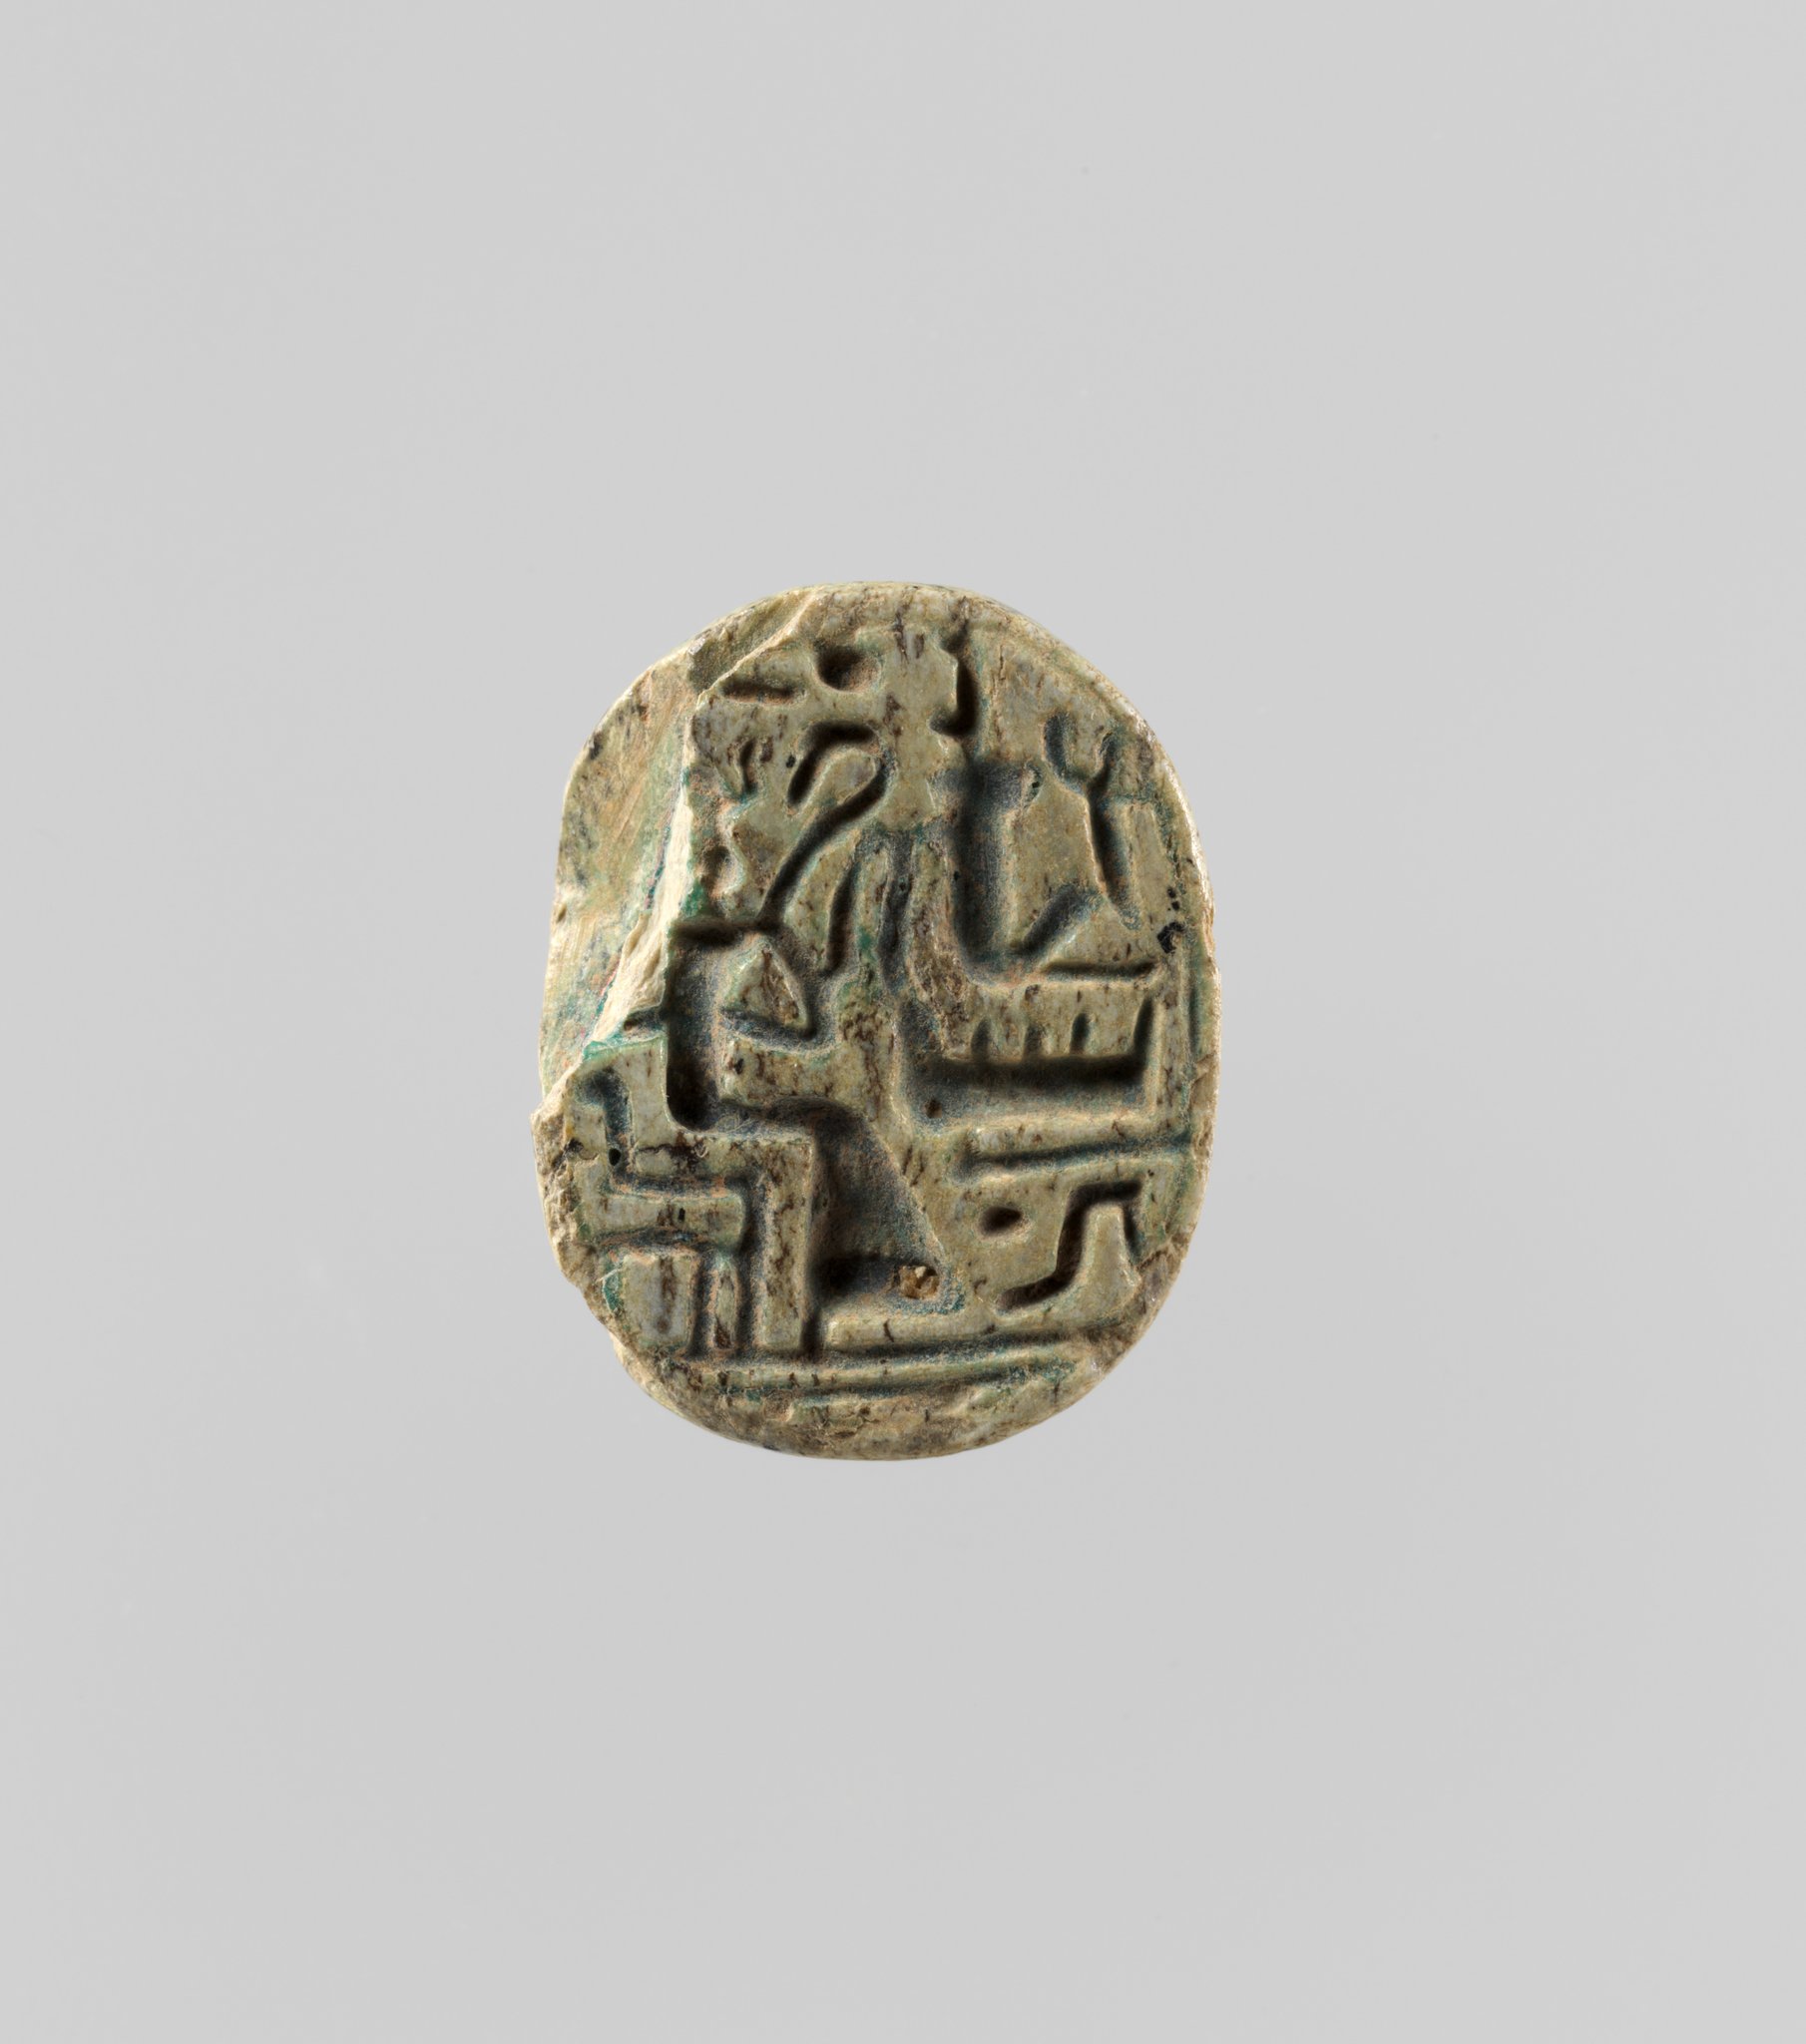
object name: scarab, royal name, ramesses iv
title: Scarab Inscribed with the Name of Ramesses IV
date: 1153-1147 BCE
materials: glaze, stone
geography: egypt